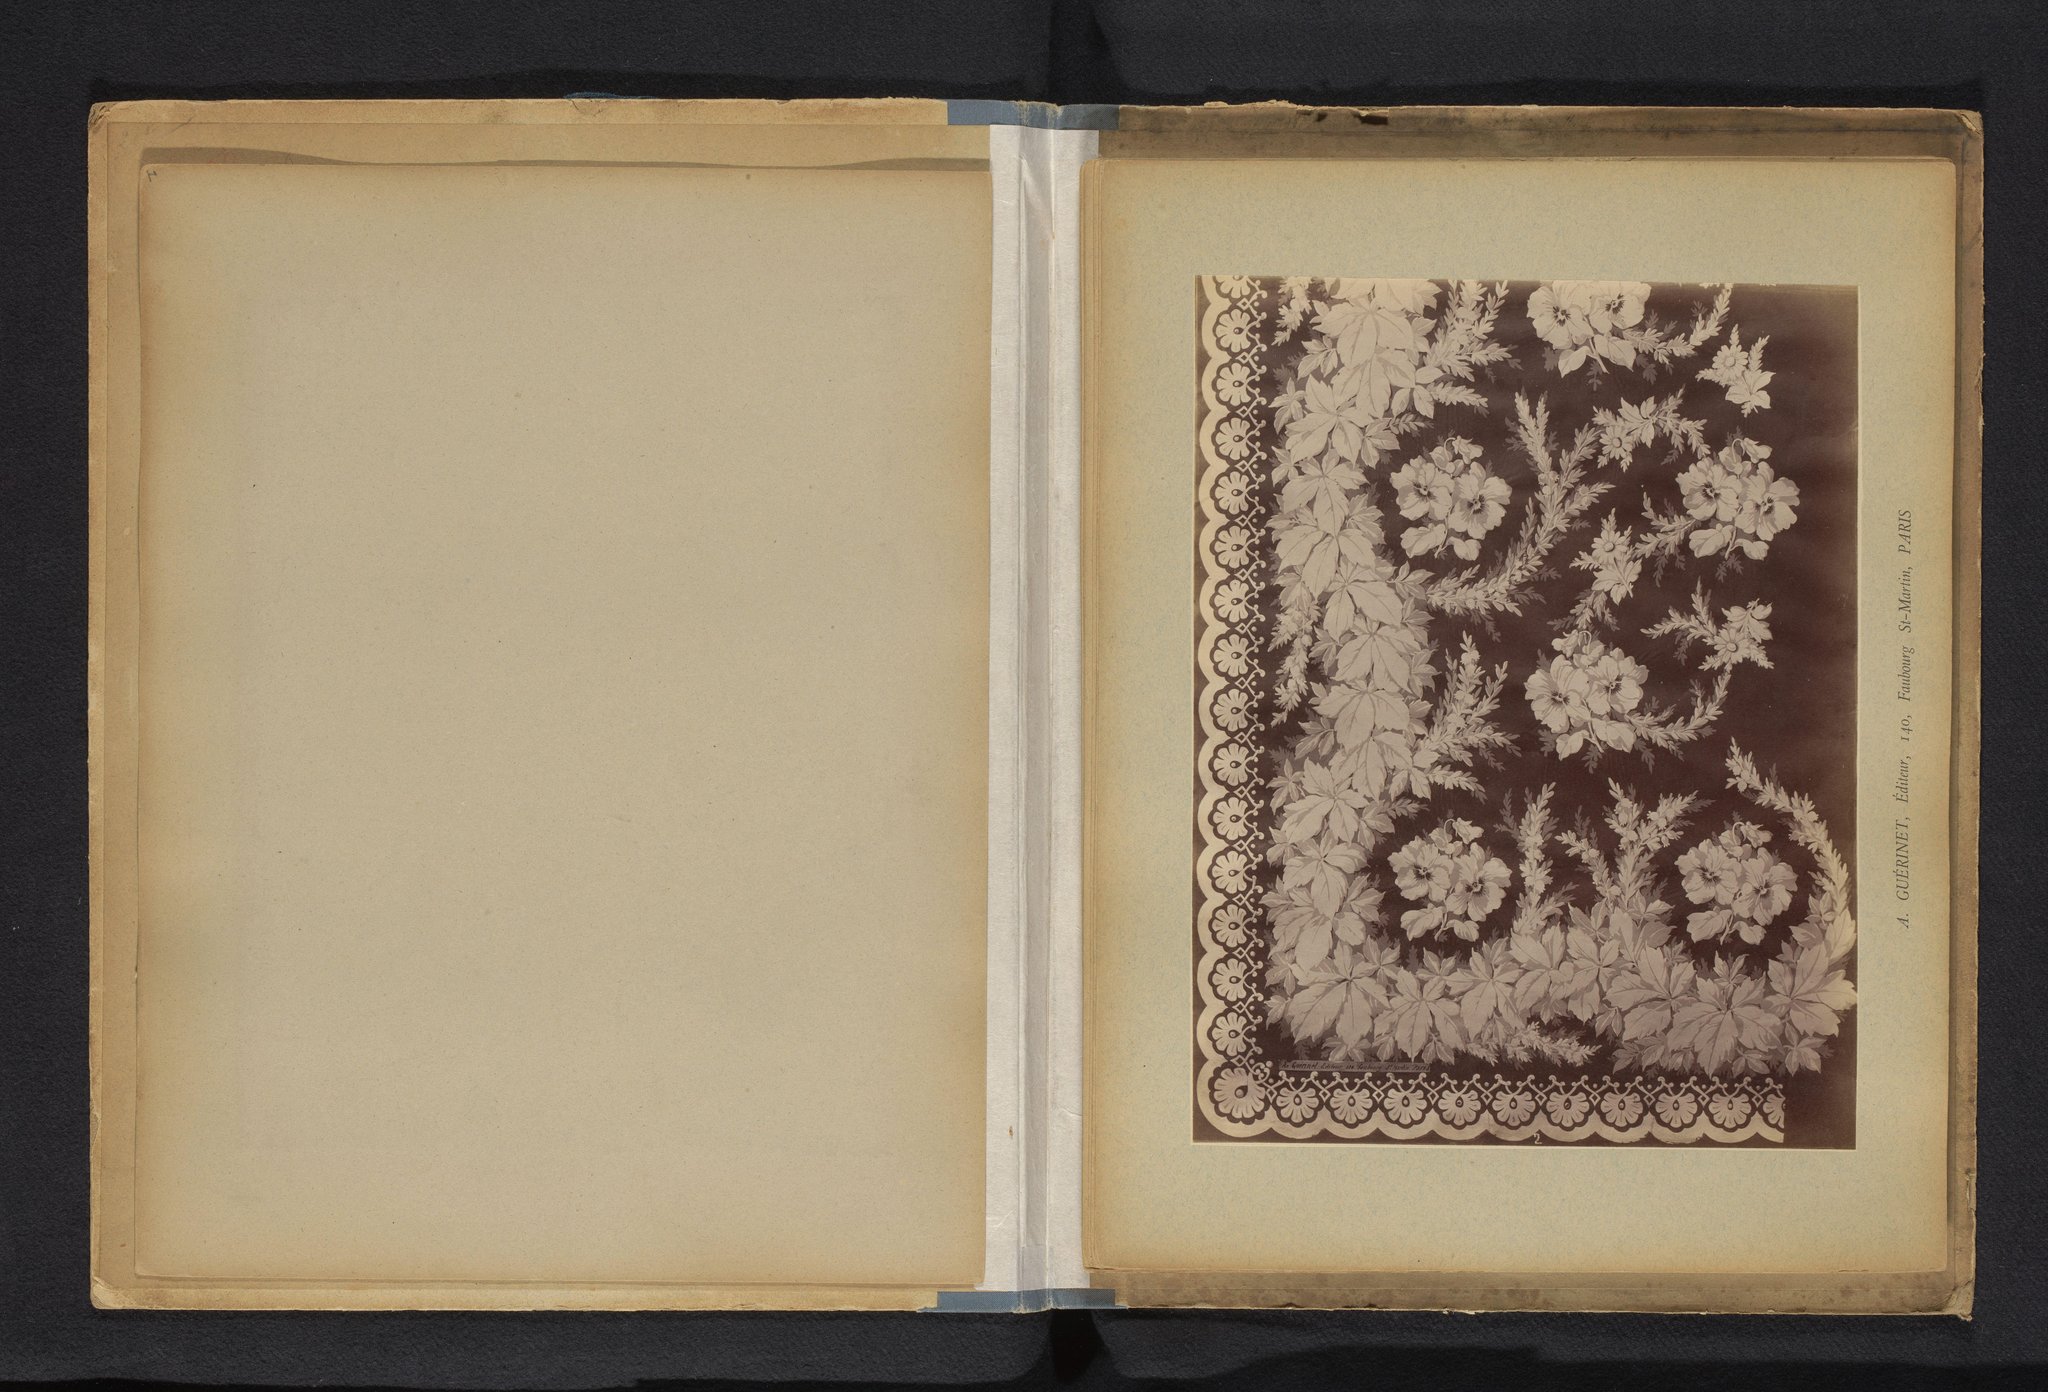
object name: page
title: Fotoreproductie van een decoratief bloemenpatroon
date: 1890-1900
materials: photographic support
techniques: albumen print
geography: paris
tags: flowers ~ ornament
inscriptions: number: ‘2’